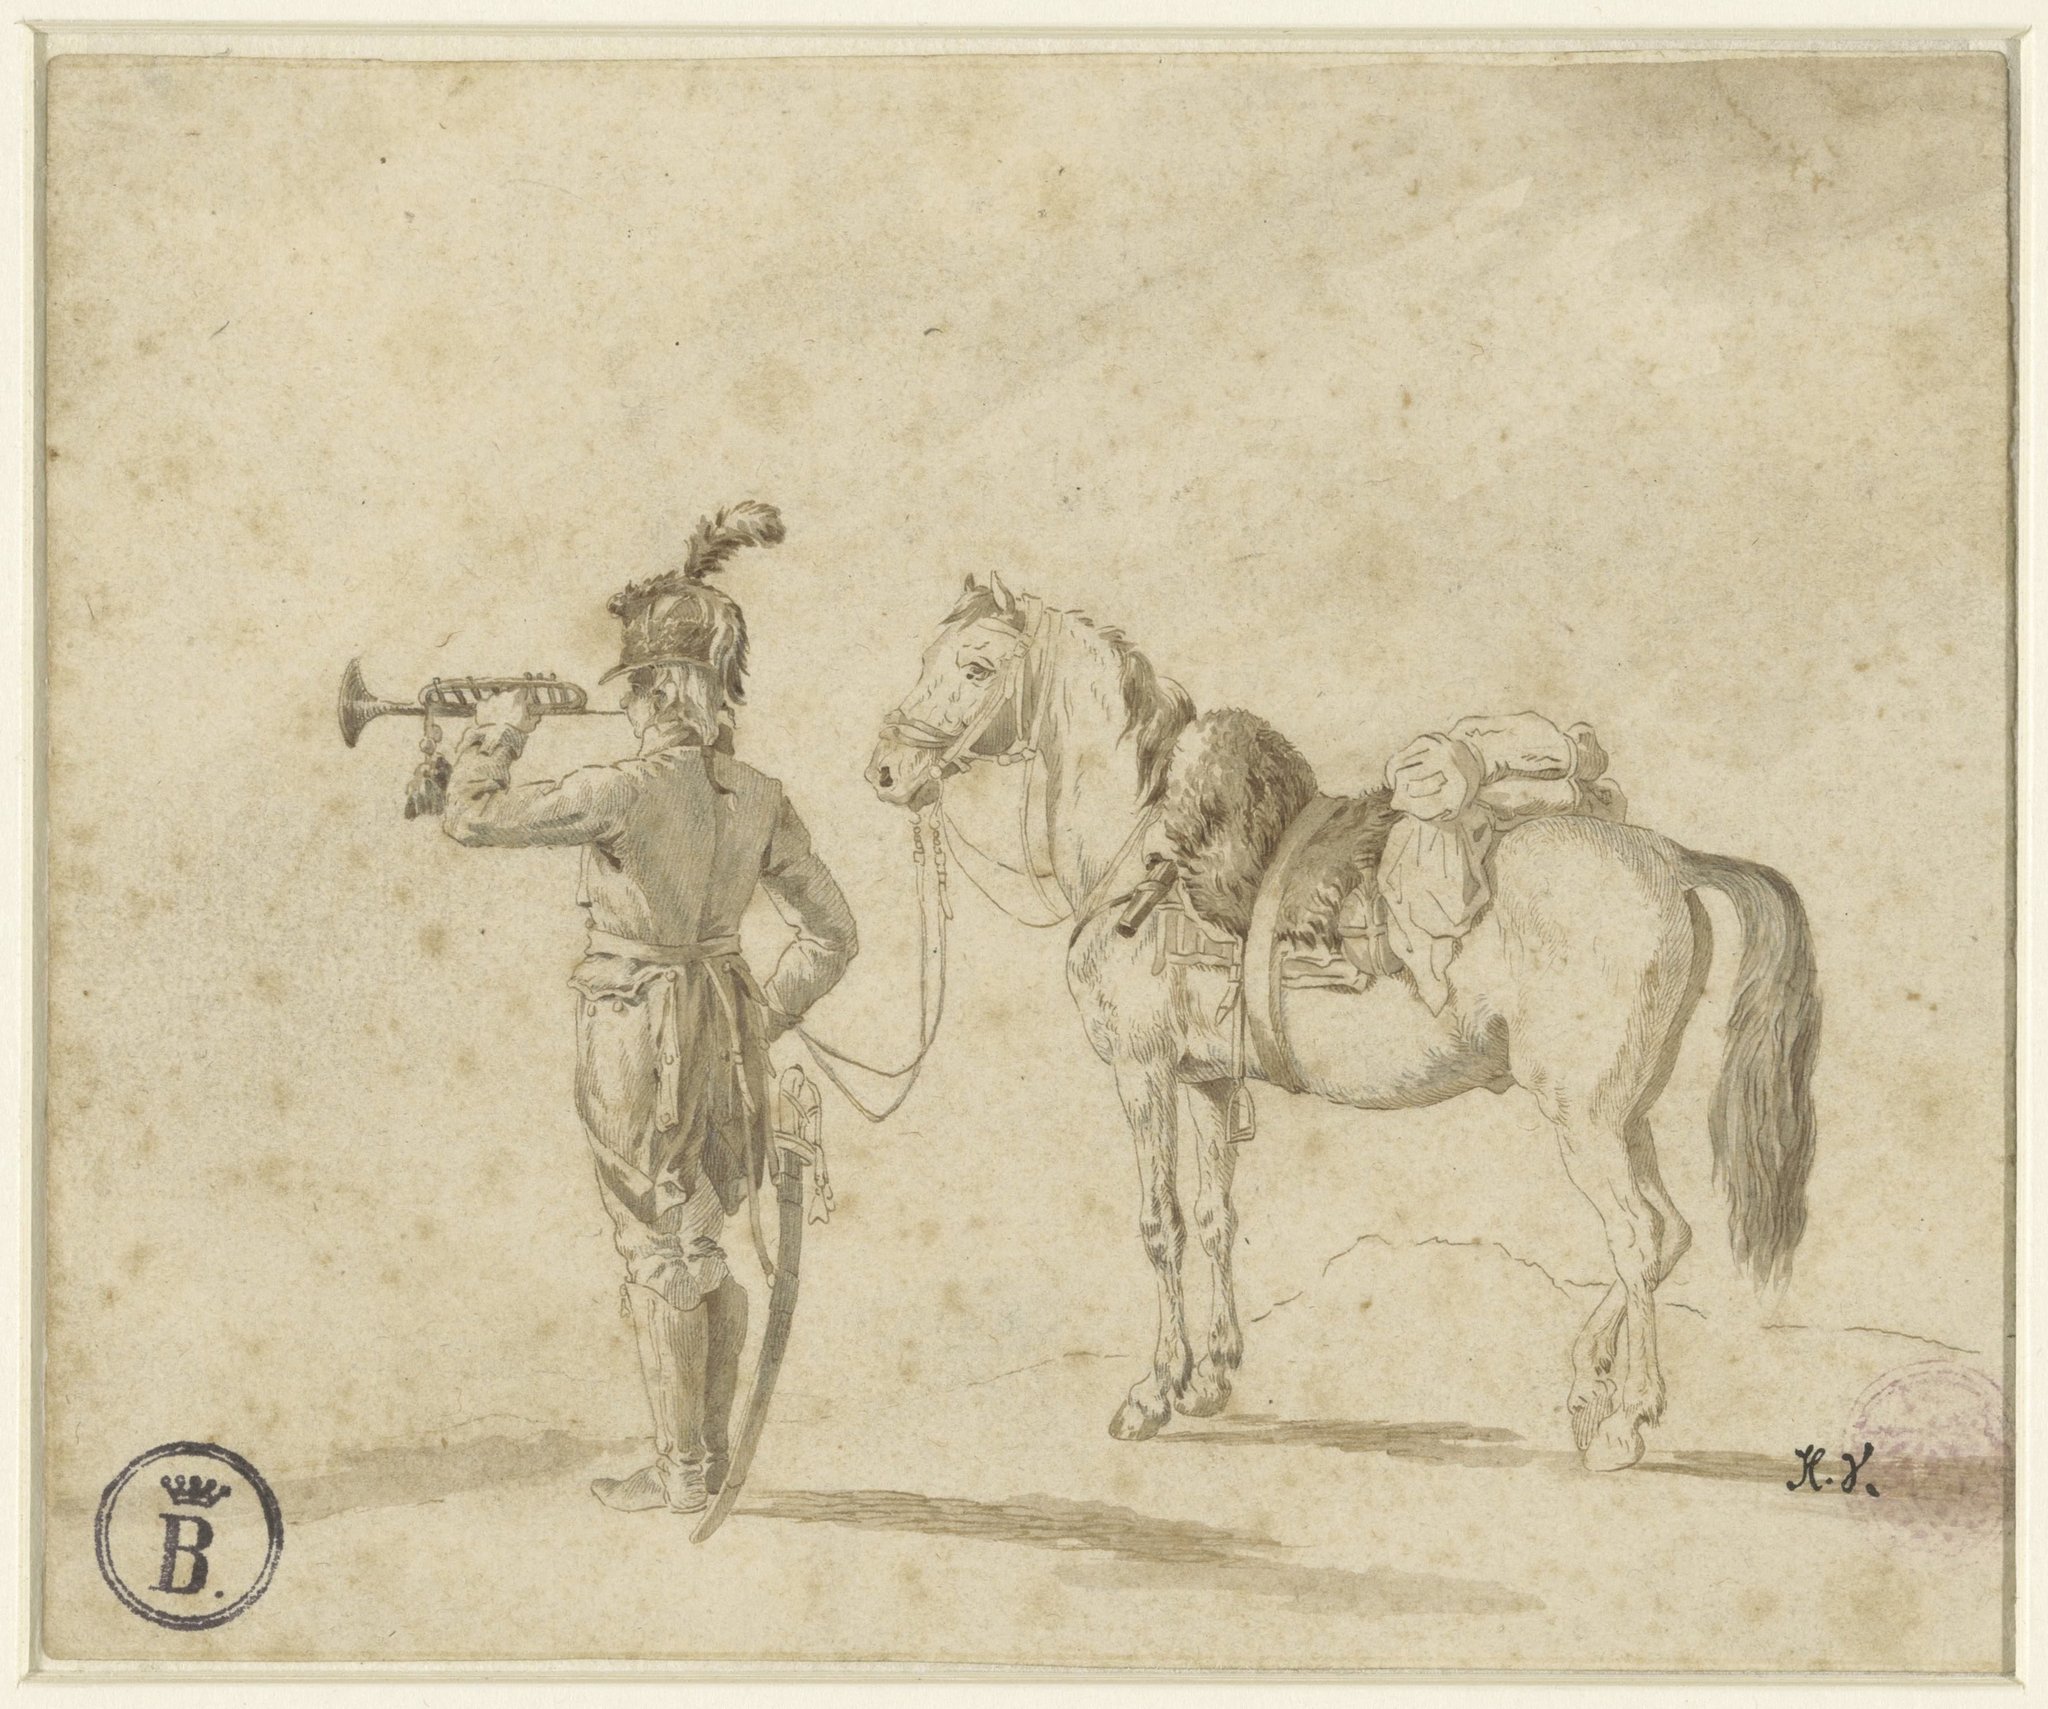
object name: drawing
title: Trompetter naast paard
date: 1799-1863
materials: ink, paper, pencil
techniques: brush, pen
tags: horse, (military) signals, the soldier; the soldier's life (+ cavalry, horsemen)